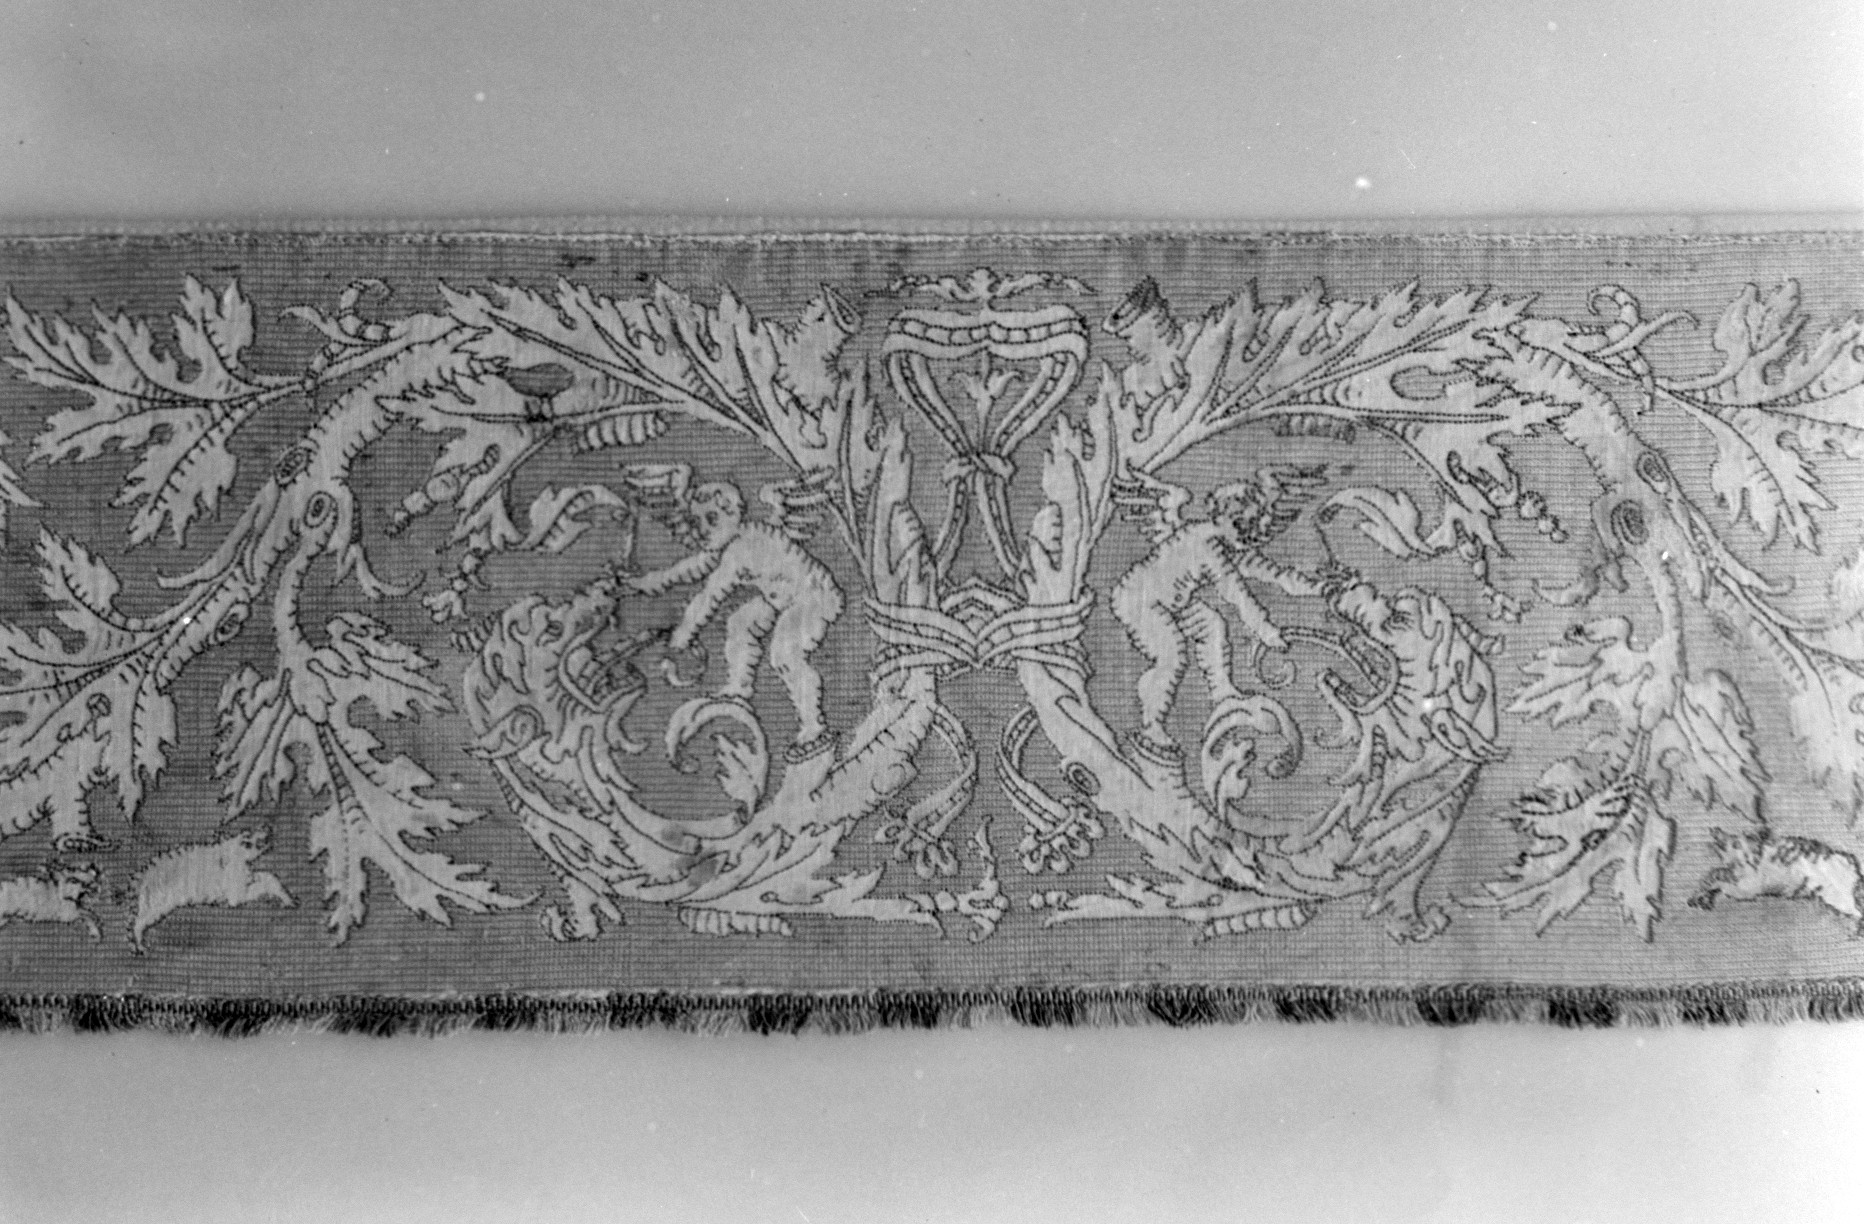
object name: border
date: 1551-1600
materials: linen, silk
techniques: embroidery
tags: putti